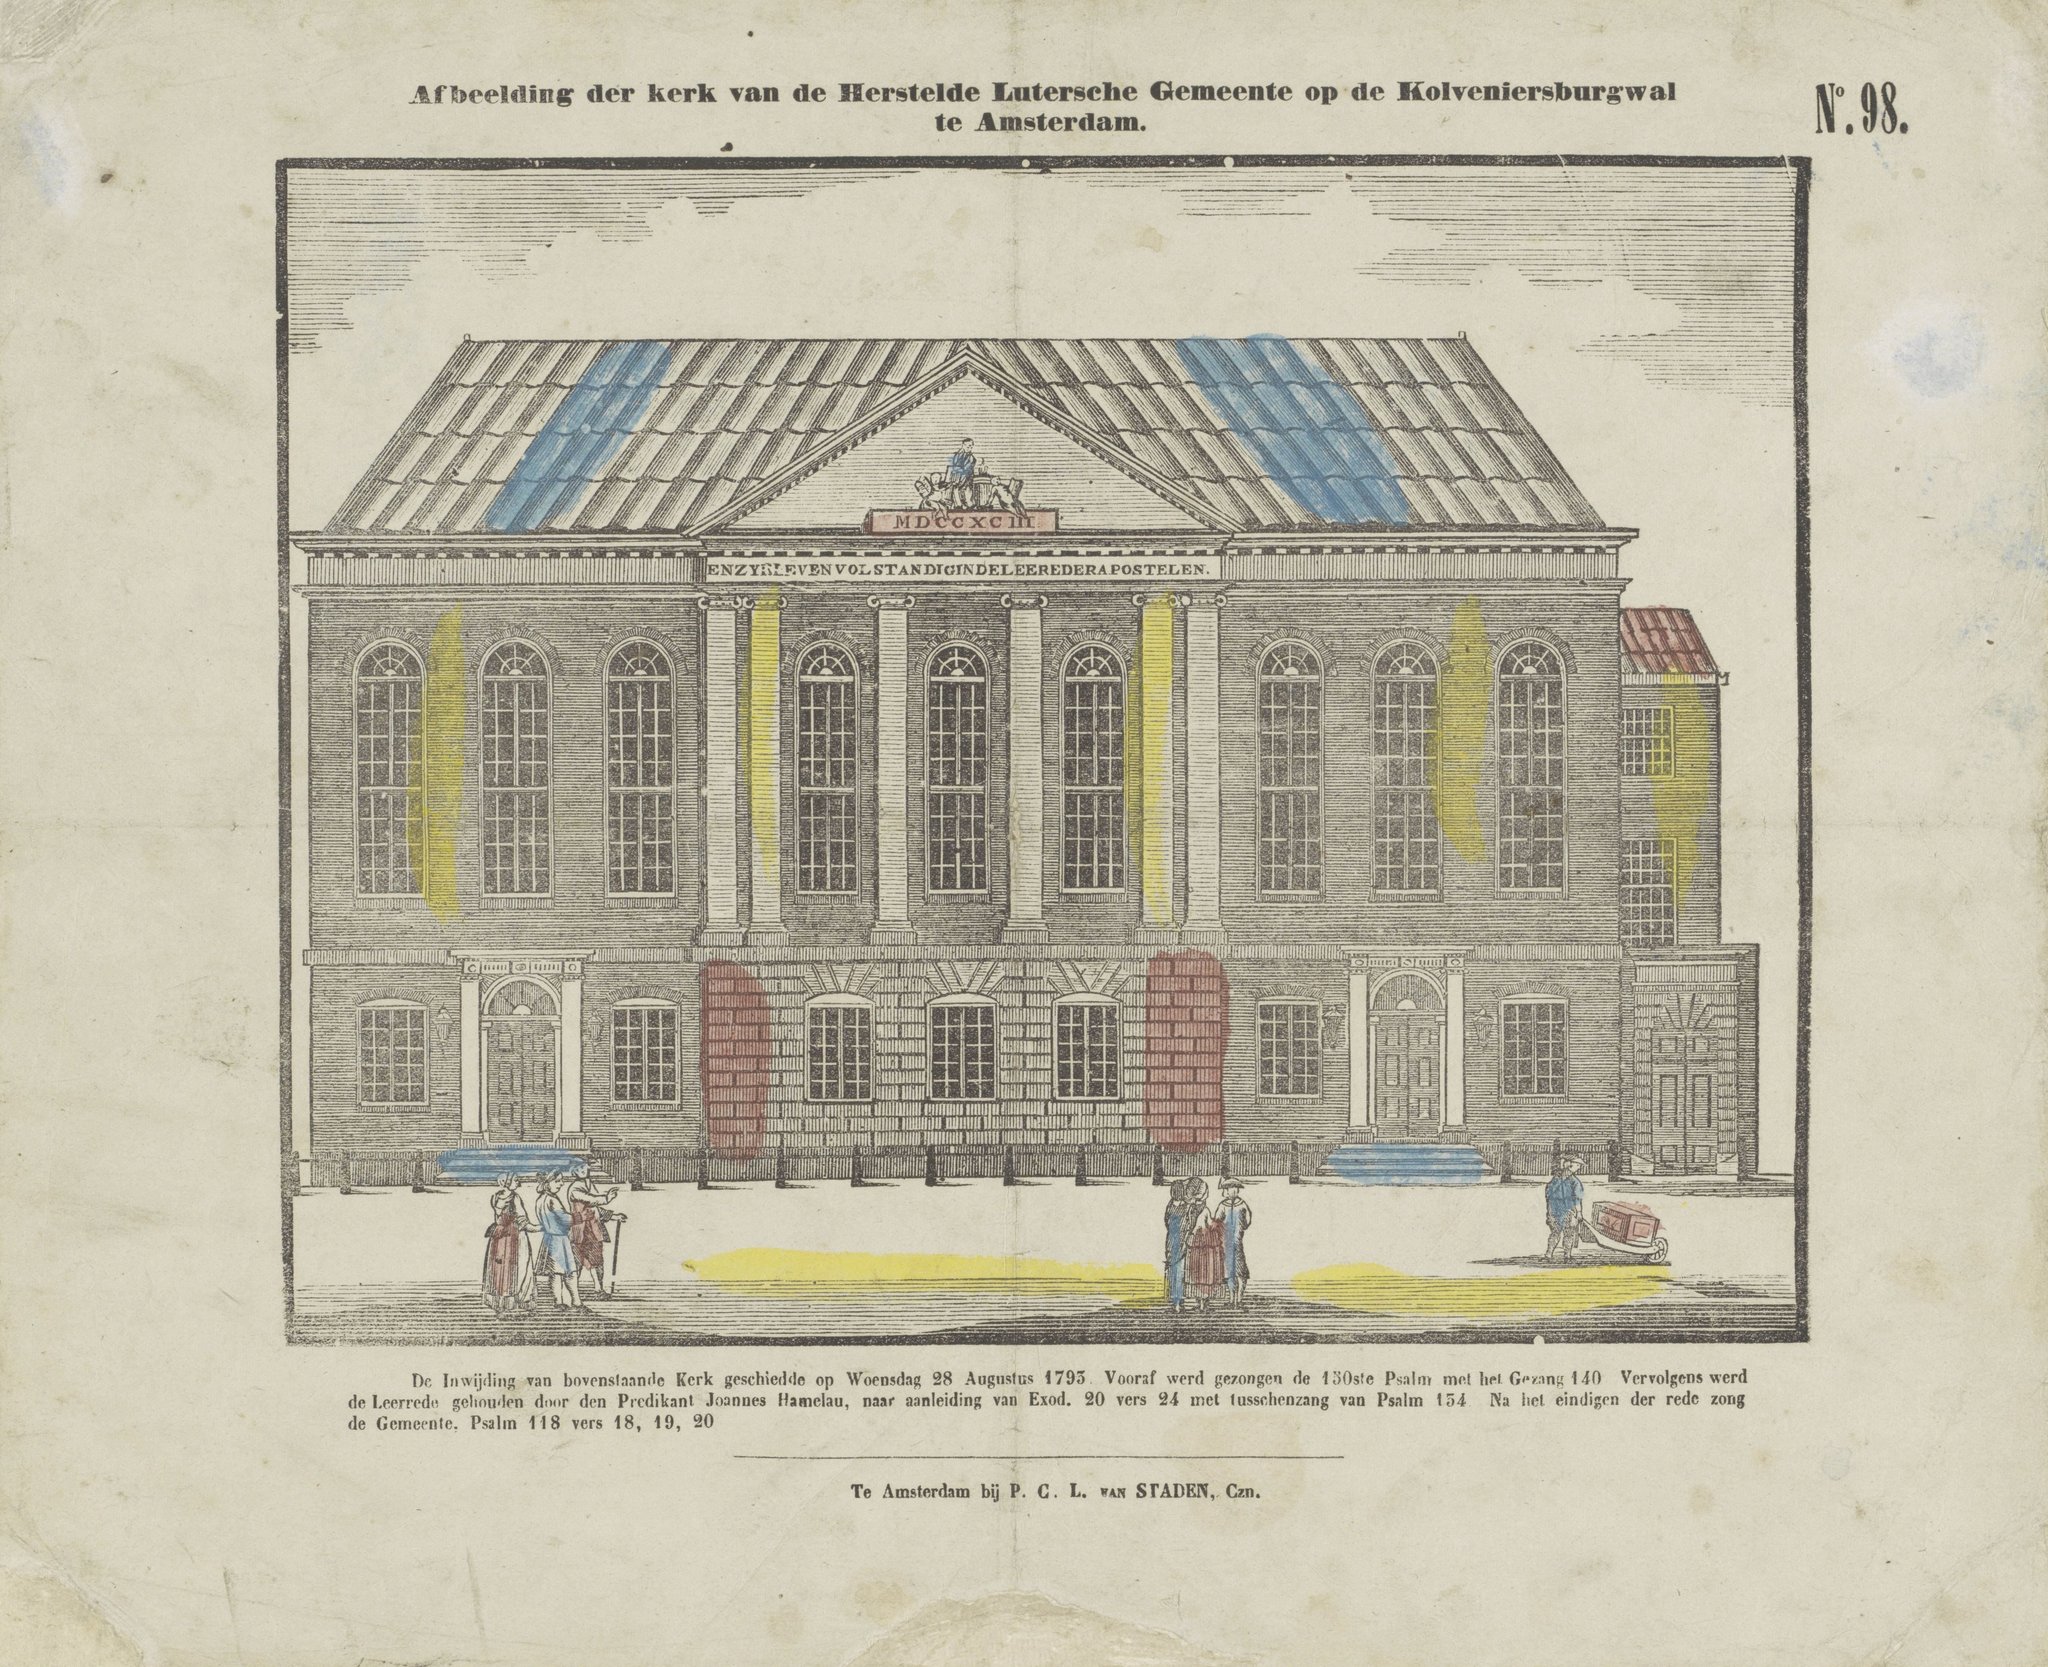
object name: popular print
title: Afbeelding der kerk van de herstelde Lutersche Gemeente op de Kolveniersburgwal te Amsterdam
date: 1850-1870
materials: paper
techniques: colour, letterpress printing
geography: netherlands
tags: lutherse gemeente te amsterdam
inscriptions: collector's mark: Lugt 2760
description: Blad met een grote voorstelling van de Lutherse Gemeente te Amsterdam. Onder de voorstelling een onderschrift. Genummerd rechtsboven: No. 98.